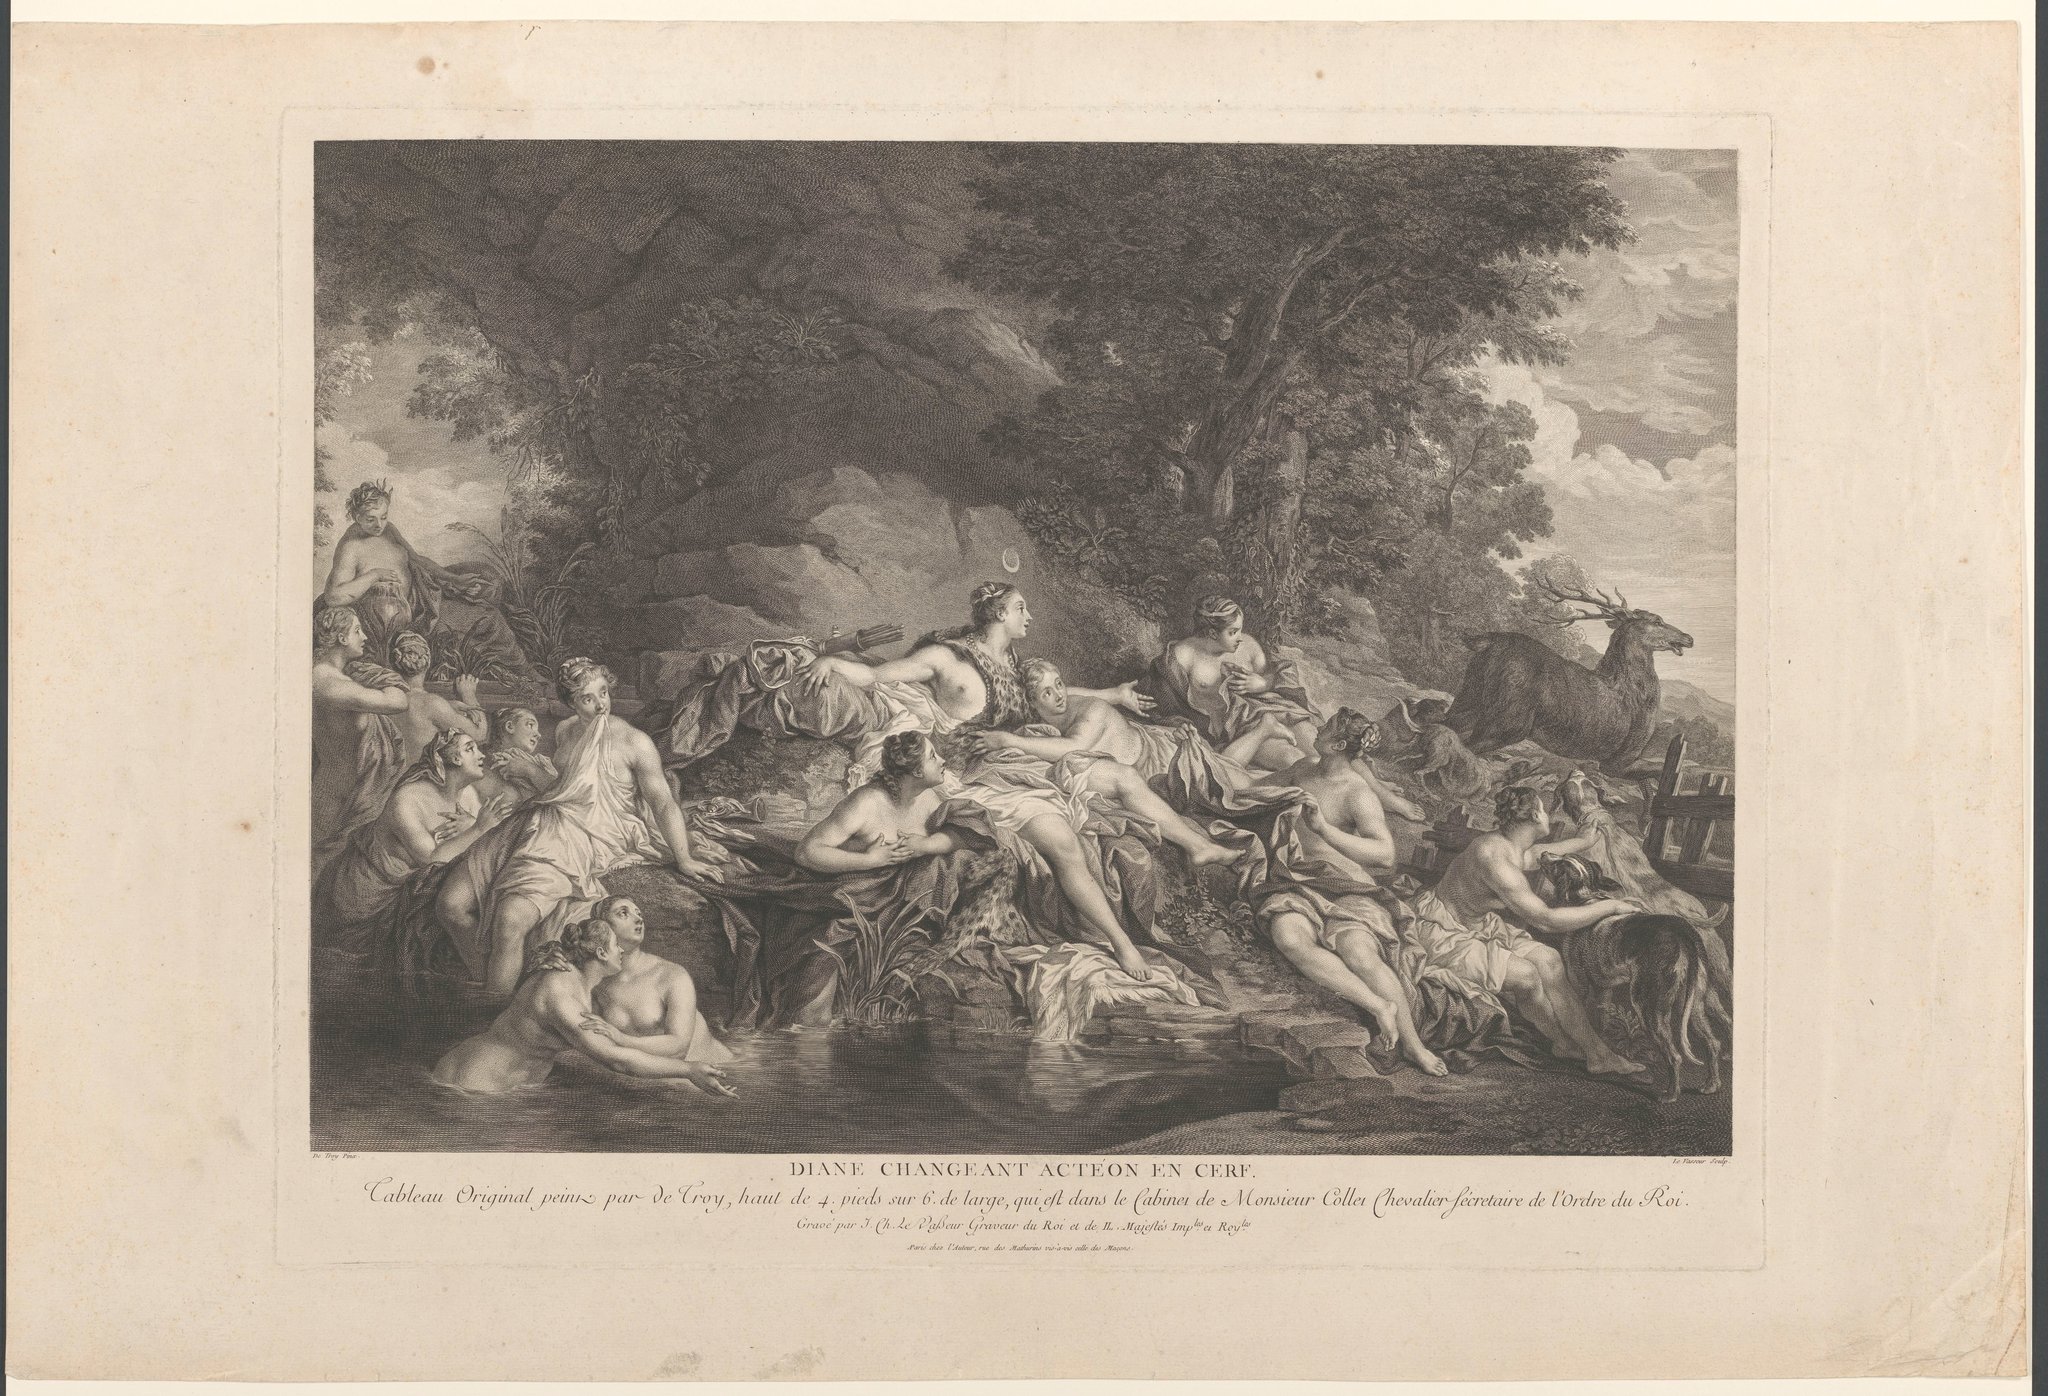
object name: print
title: Diane changeant Actéon en cerf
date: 1749-1816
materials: paper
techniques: engraving, etching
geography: paris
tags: hoofed animals: deer, actaeon changed into a stag: as punishment for seeing her bathe, diana changes actaeon, the hunter, into a stag (ovid, metamorphoses iii 193)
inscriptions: collector's mark: Lugt 240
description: Met drieregelig onderschrift in het Frans.